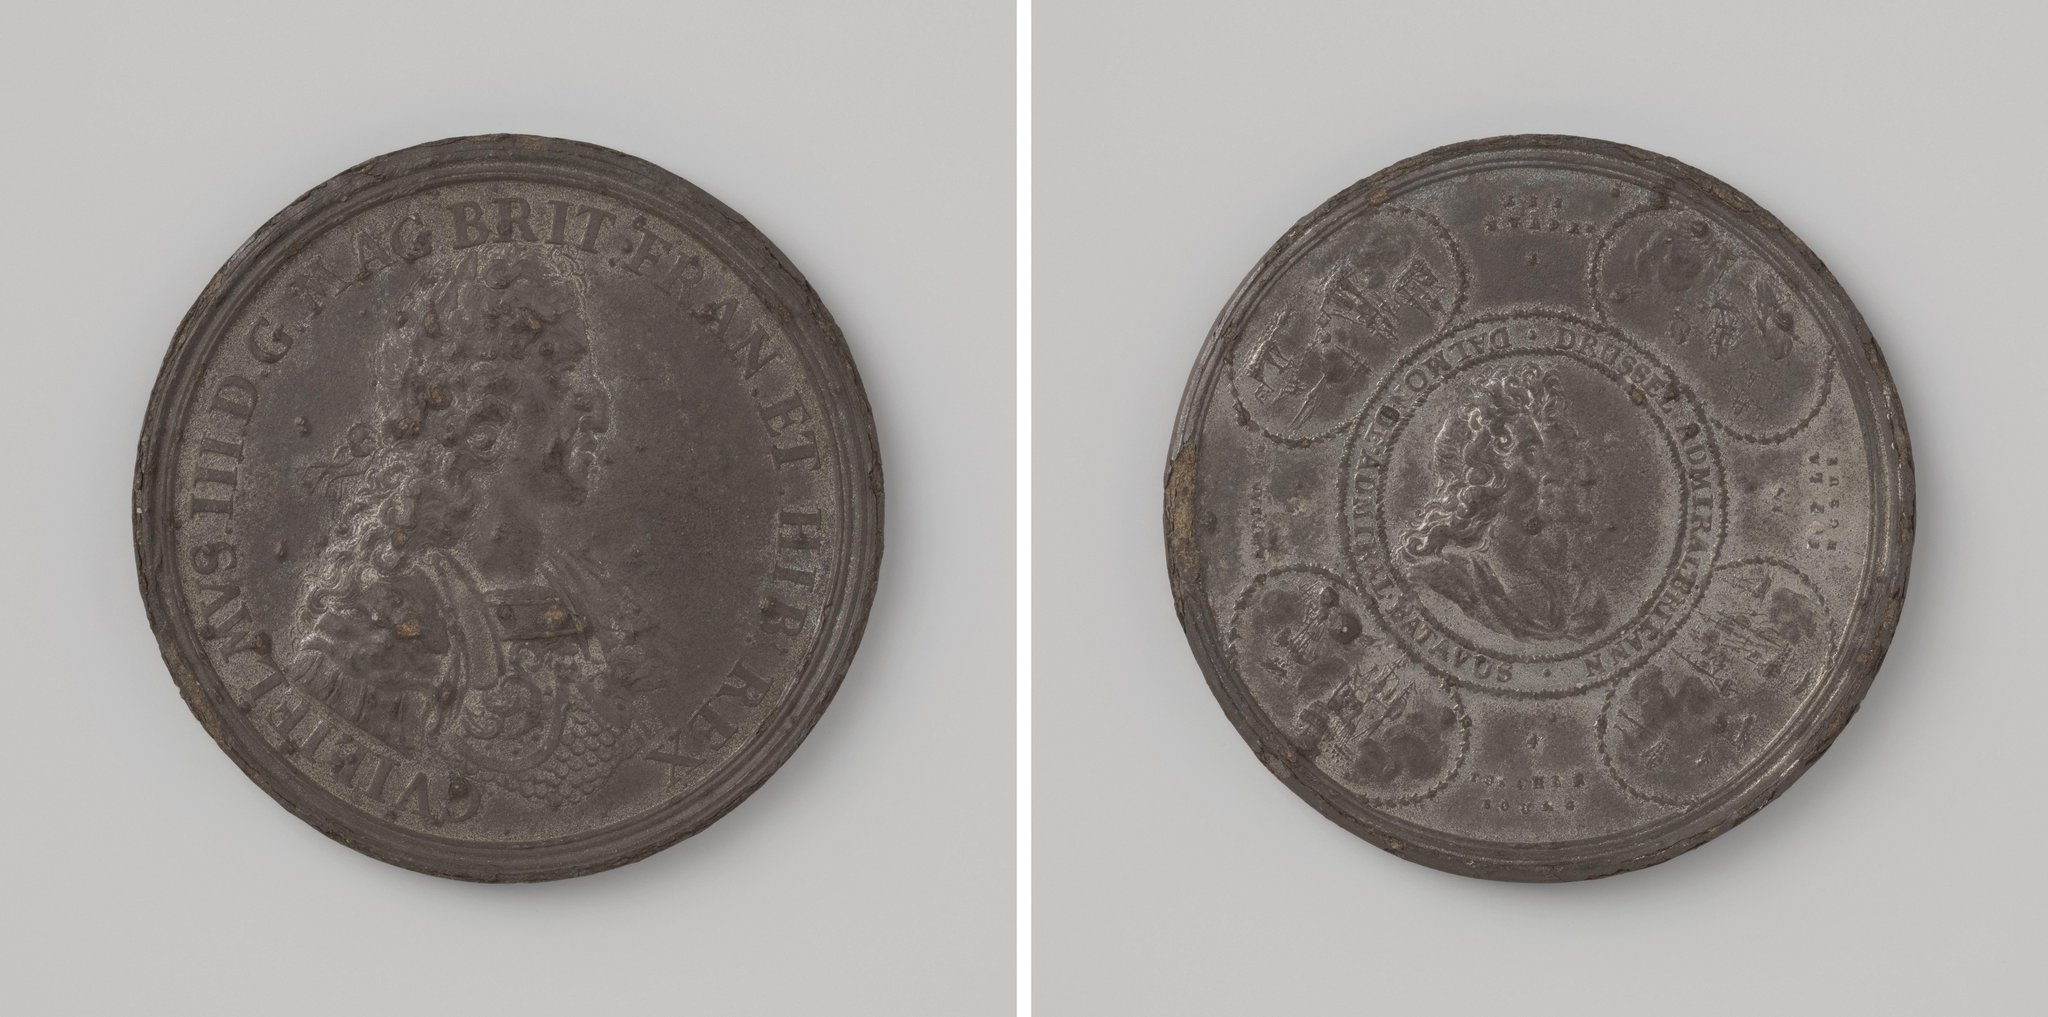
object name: history medal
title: Zeeslag bij Kaap La Hogue 1692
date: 1692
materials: tin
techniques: casting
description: Tinnen penning, op de voorzijde het geharnaste borstbeeld van koning-stadhouder Willem III met omschrift, op de keerzijde in het midden de geconjugeerde borstbeelden van Willem en Mary, met omschrift, met daarbuiten vier oovale medaillons met taferelen uit de zeeslag waarussen tekst.